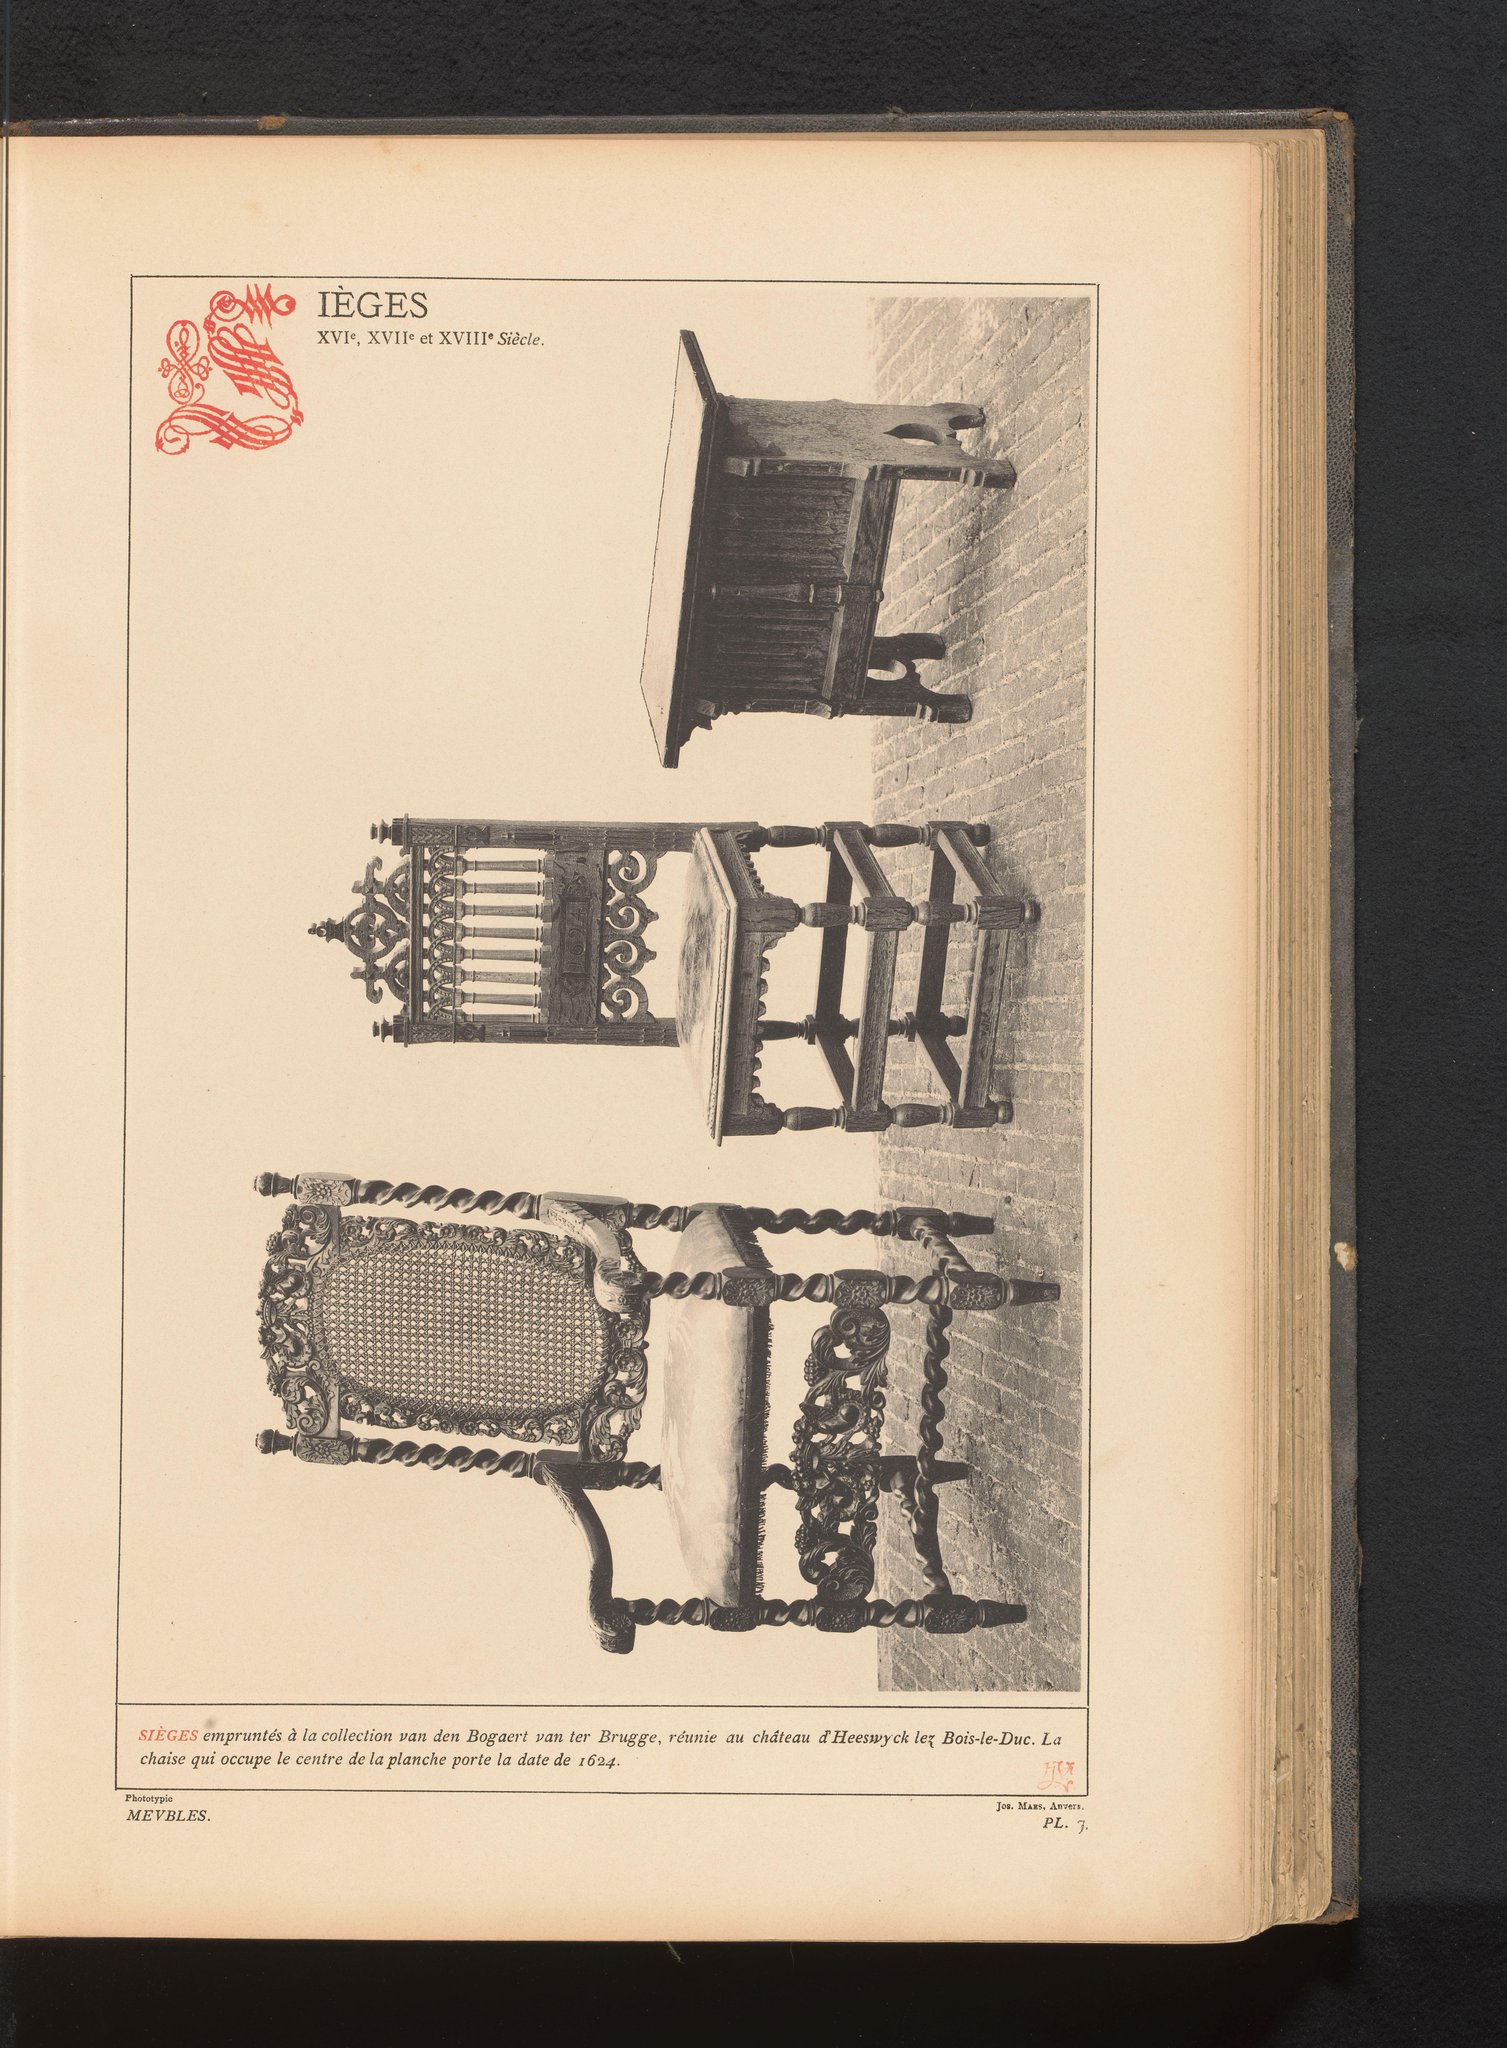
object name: page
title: Sièges, XVIe, XVIIe et XVIIIe Siècle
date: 1881-1889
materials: paper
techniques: photograph, photolithography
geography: antwerp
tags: seating furniture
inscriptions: monogram: ‘JJvY’, inscription: ‘MEUBLES. PL. 7.’, inscription: ‘SIÈGES empruntés à (...)’